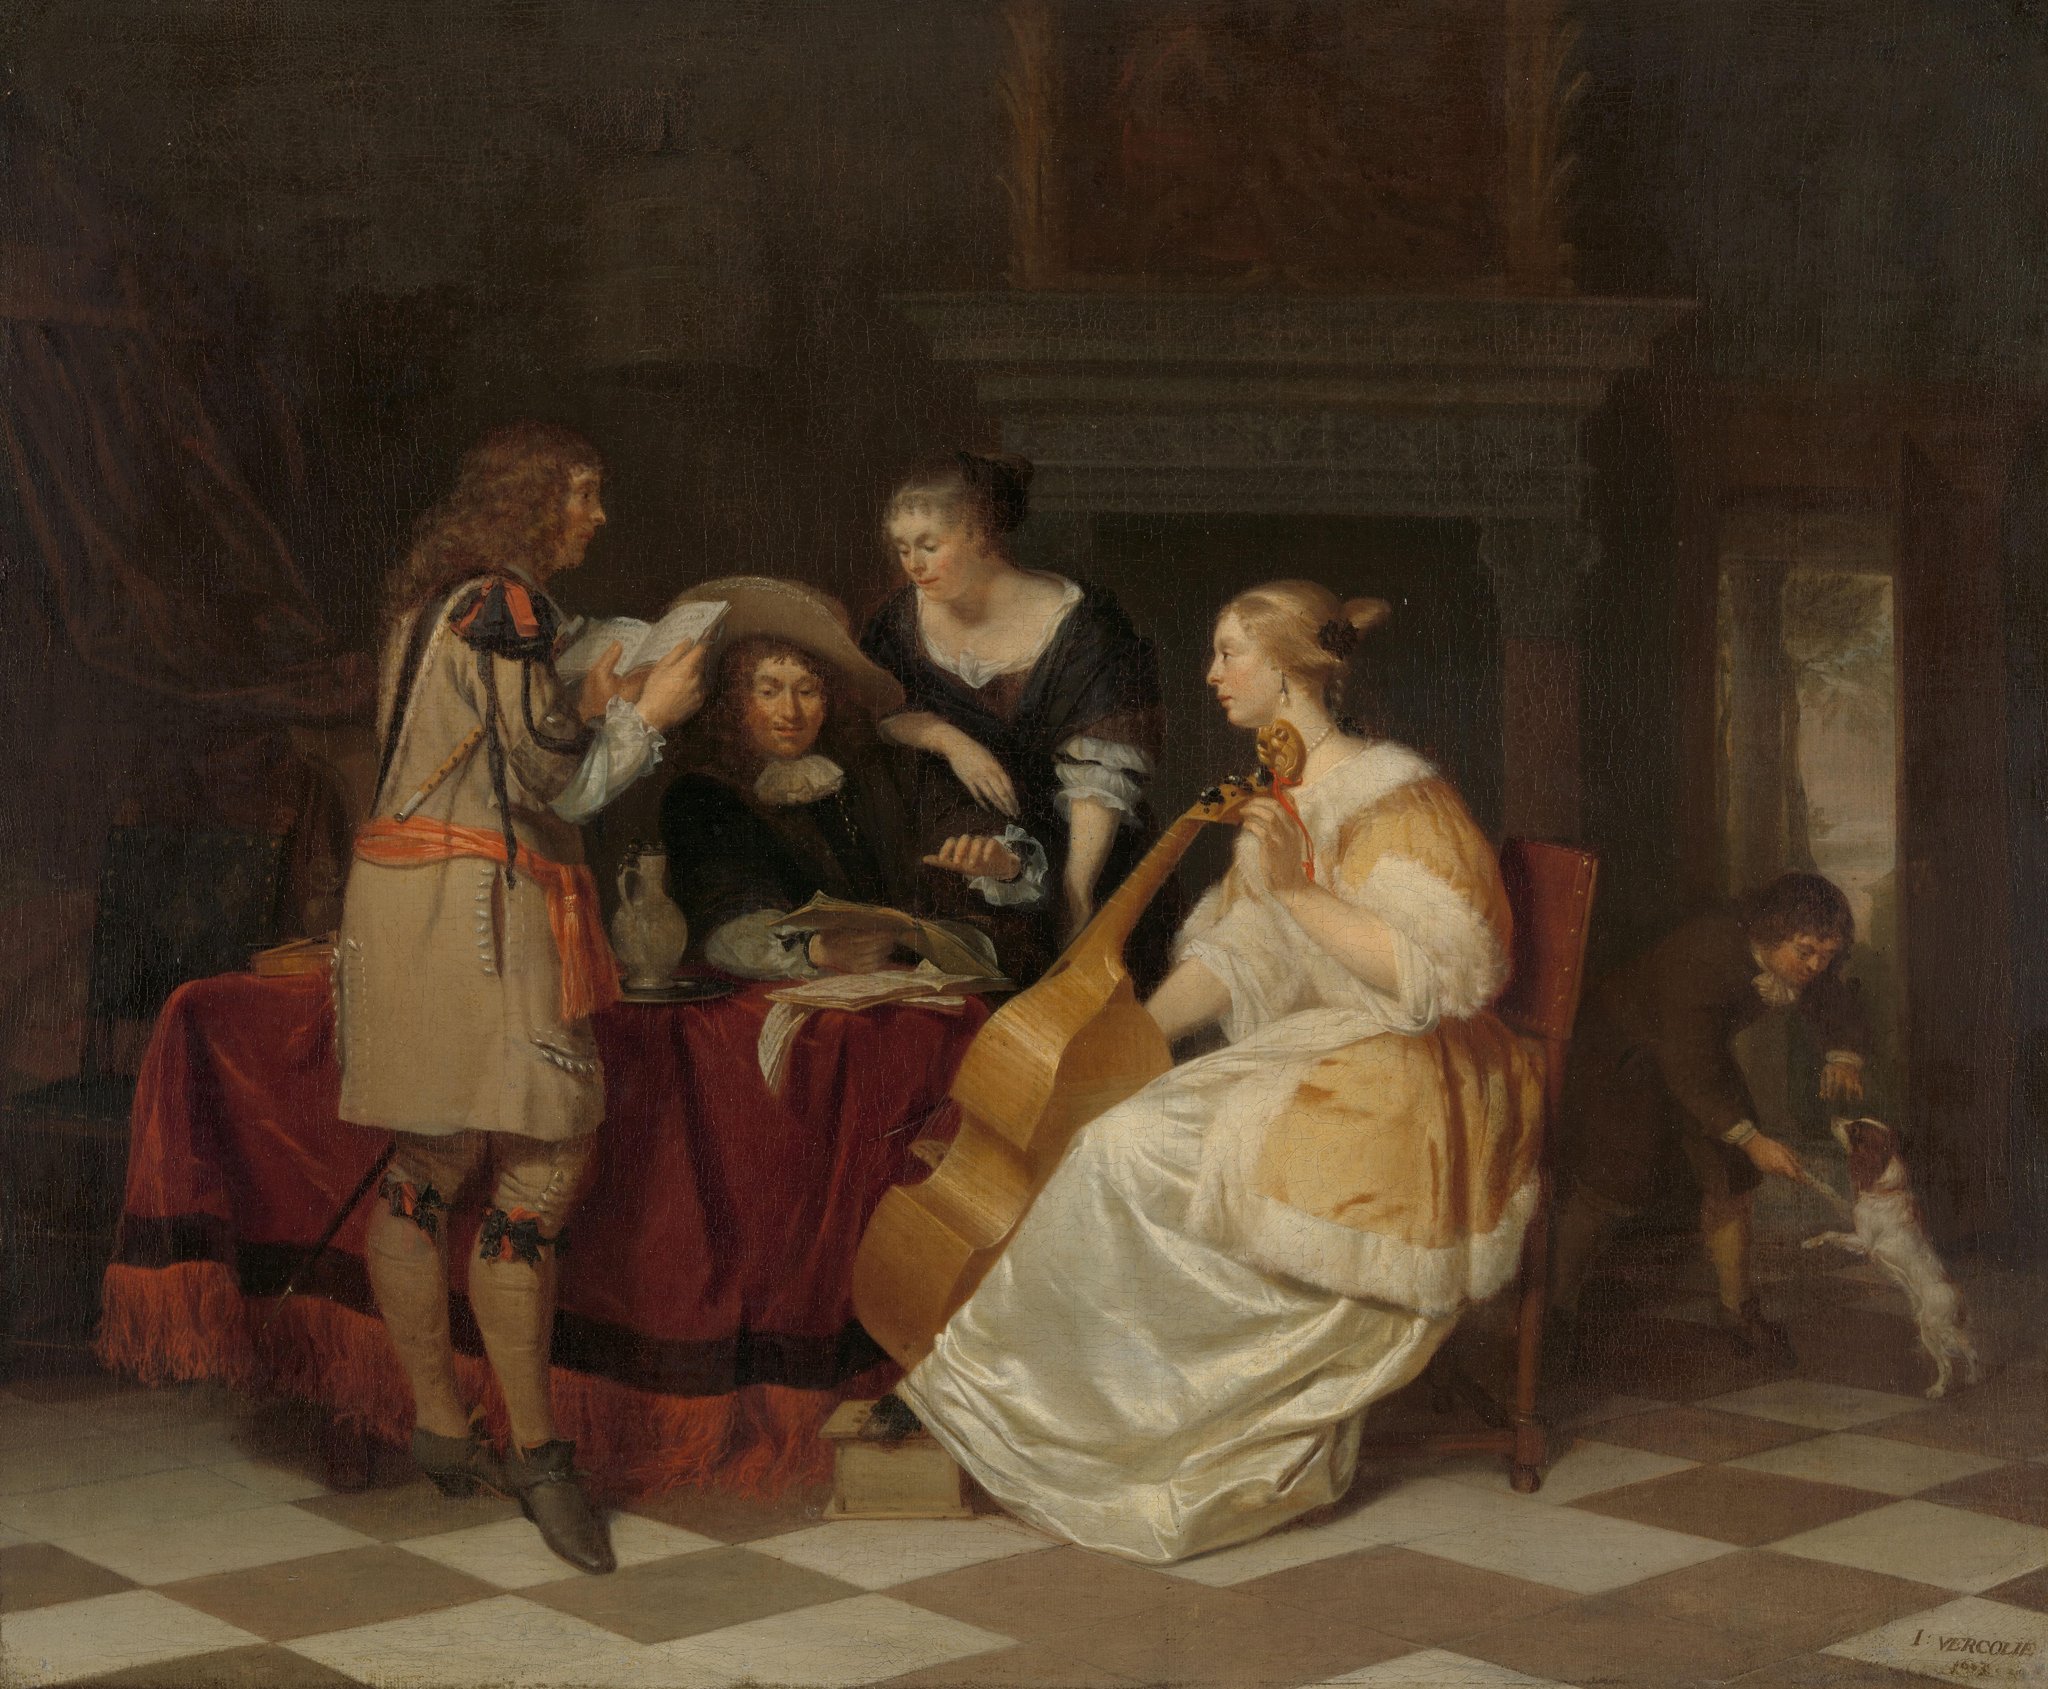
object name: painting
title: A Musical Company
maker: jan verkolje (i)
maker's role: draughtsman, painter, print maker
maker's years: 1650-1693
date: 1673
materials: canvas, oil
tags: instrumental and vocal music together, one person playing string instrument (bowed), viola, violoncello; double bass, child playing with animals, dog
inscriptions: signature and date: ‘I: Vercolie 1673’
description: Musicerend gezelschap. Interieur met twee dames en heren die rond een tafel muziek maken. Een vrouw speelt op de cello terwijl de andere drie zingen uit liedboekjes. Rechts speelt een jongen met een hond.